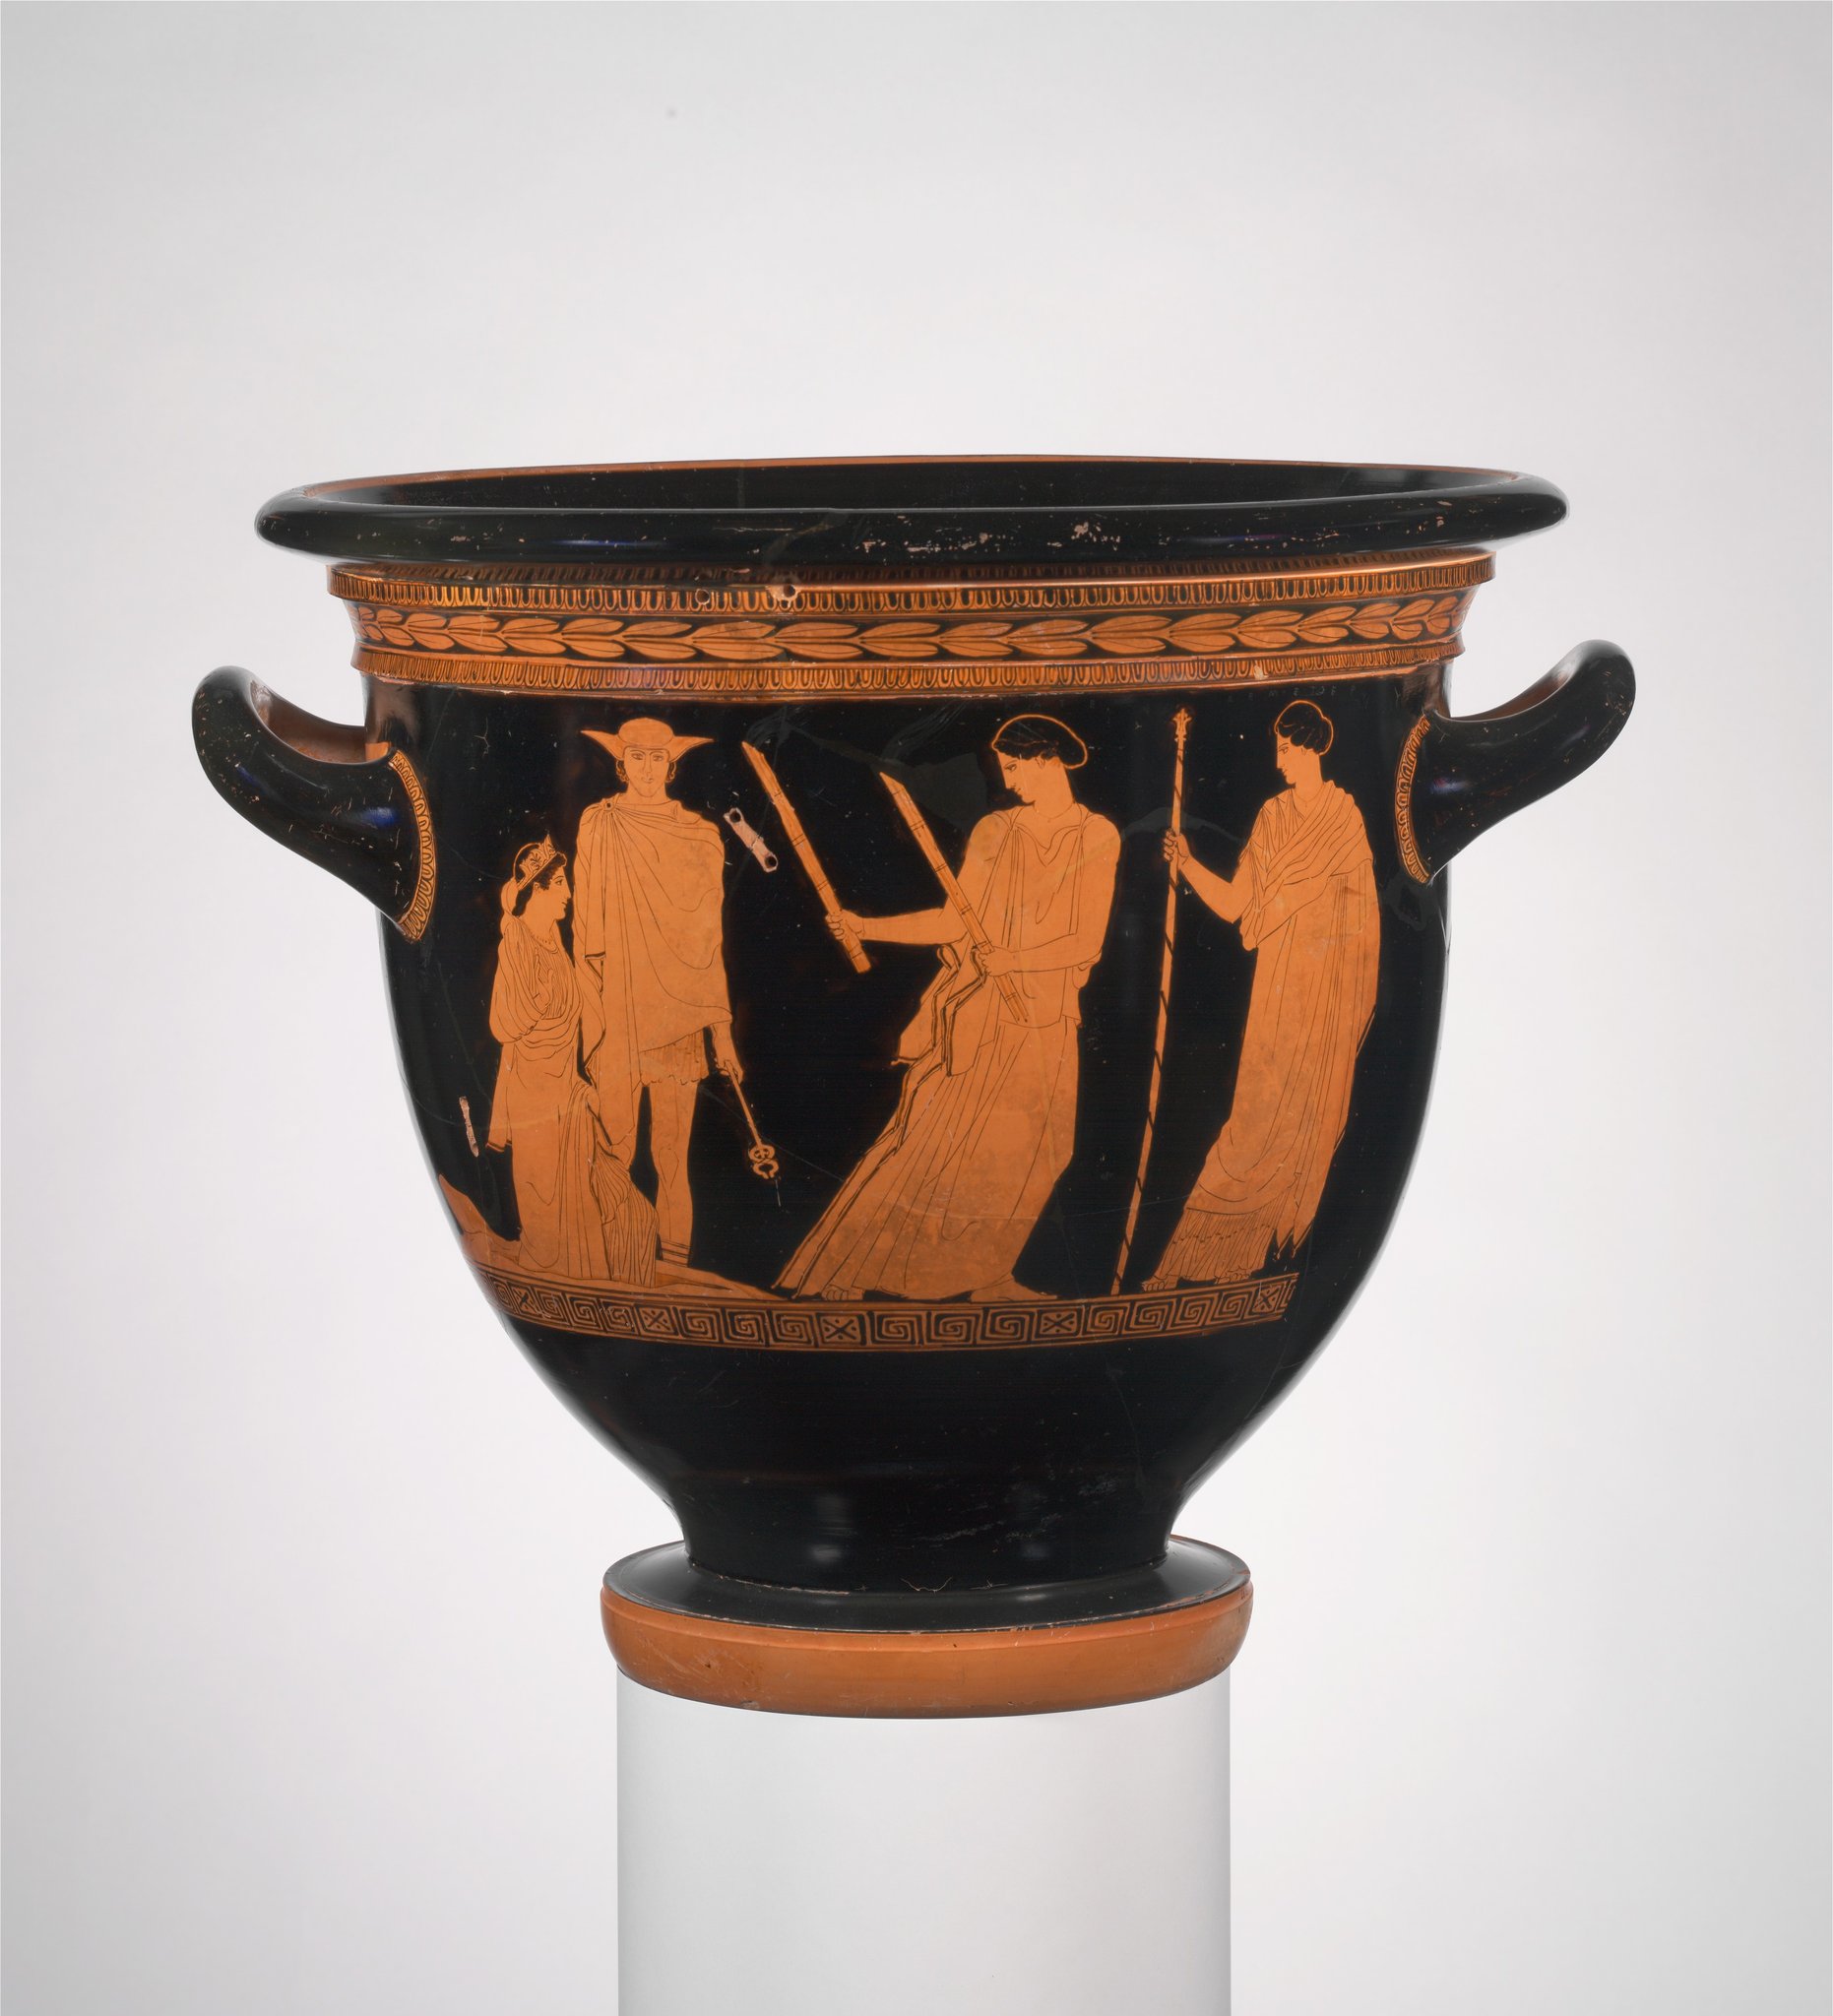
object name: bell krater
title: Terracotta bell-krater (bowl for mixing wine and water)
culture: greek, attic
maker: persephone painter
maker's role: artist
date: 440 BCE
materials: terracotta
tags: swords,men,women,hermes,persephone,demeter